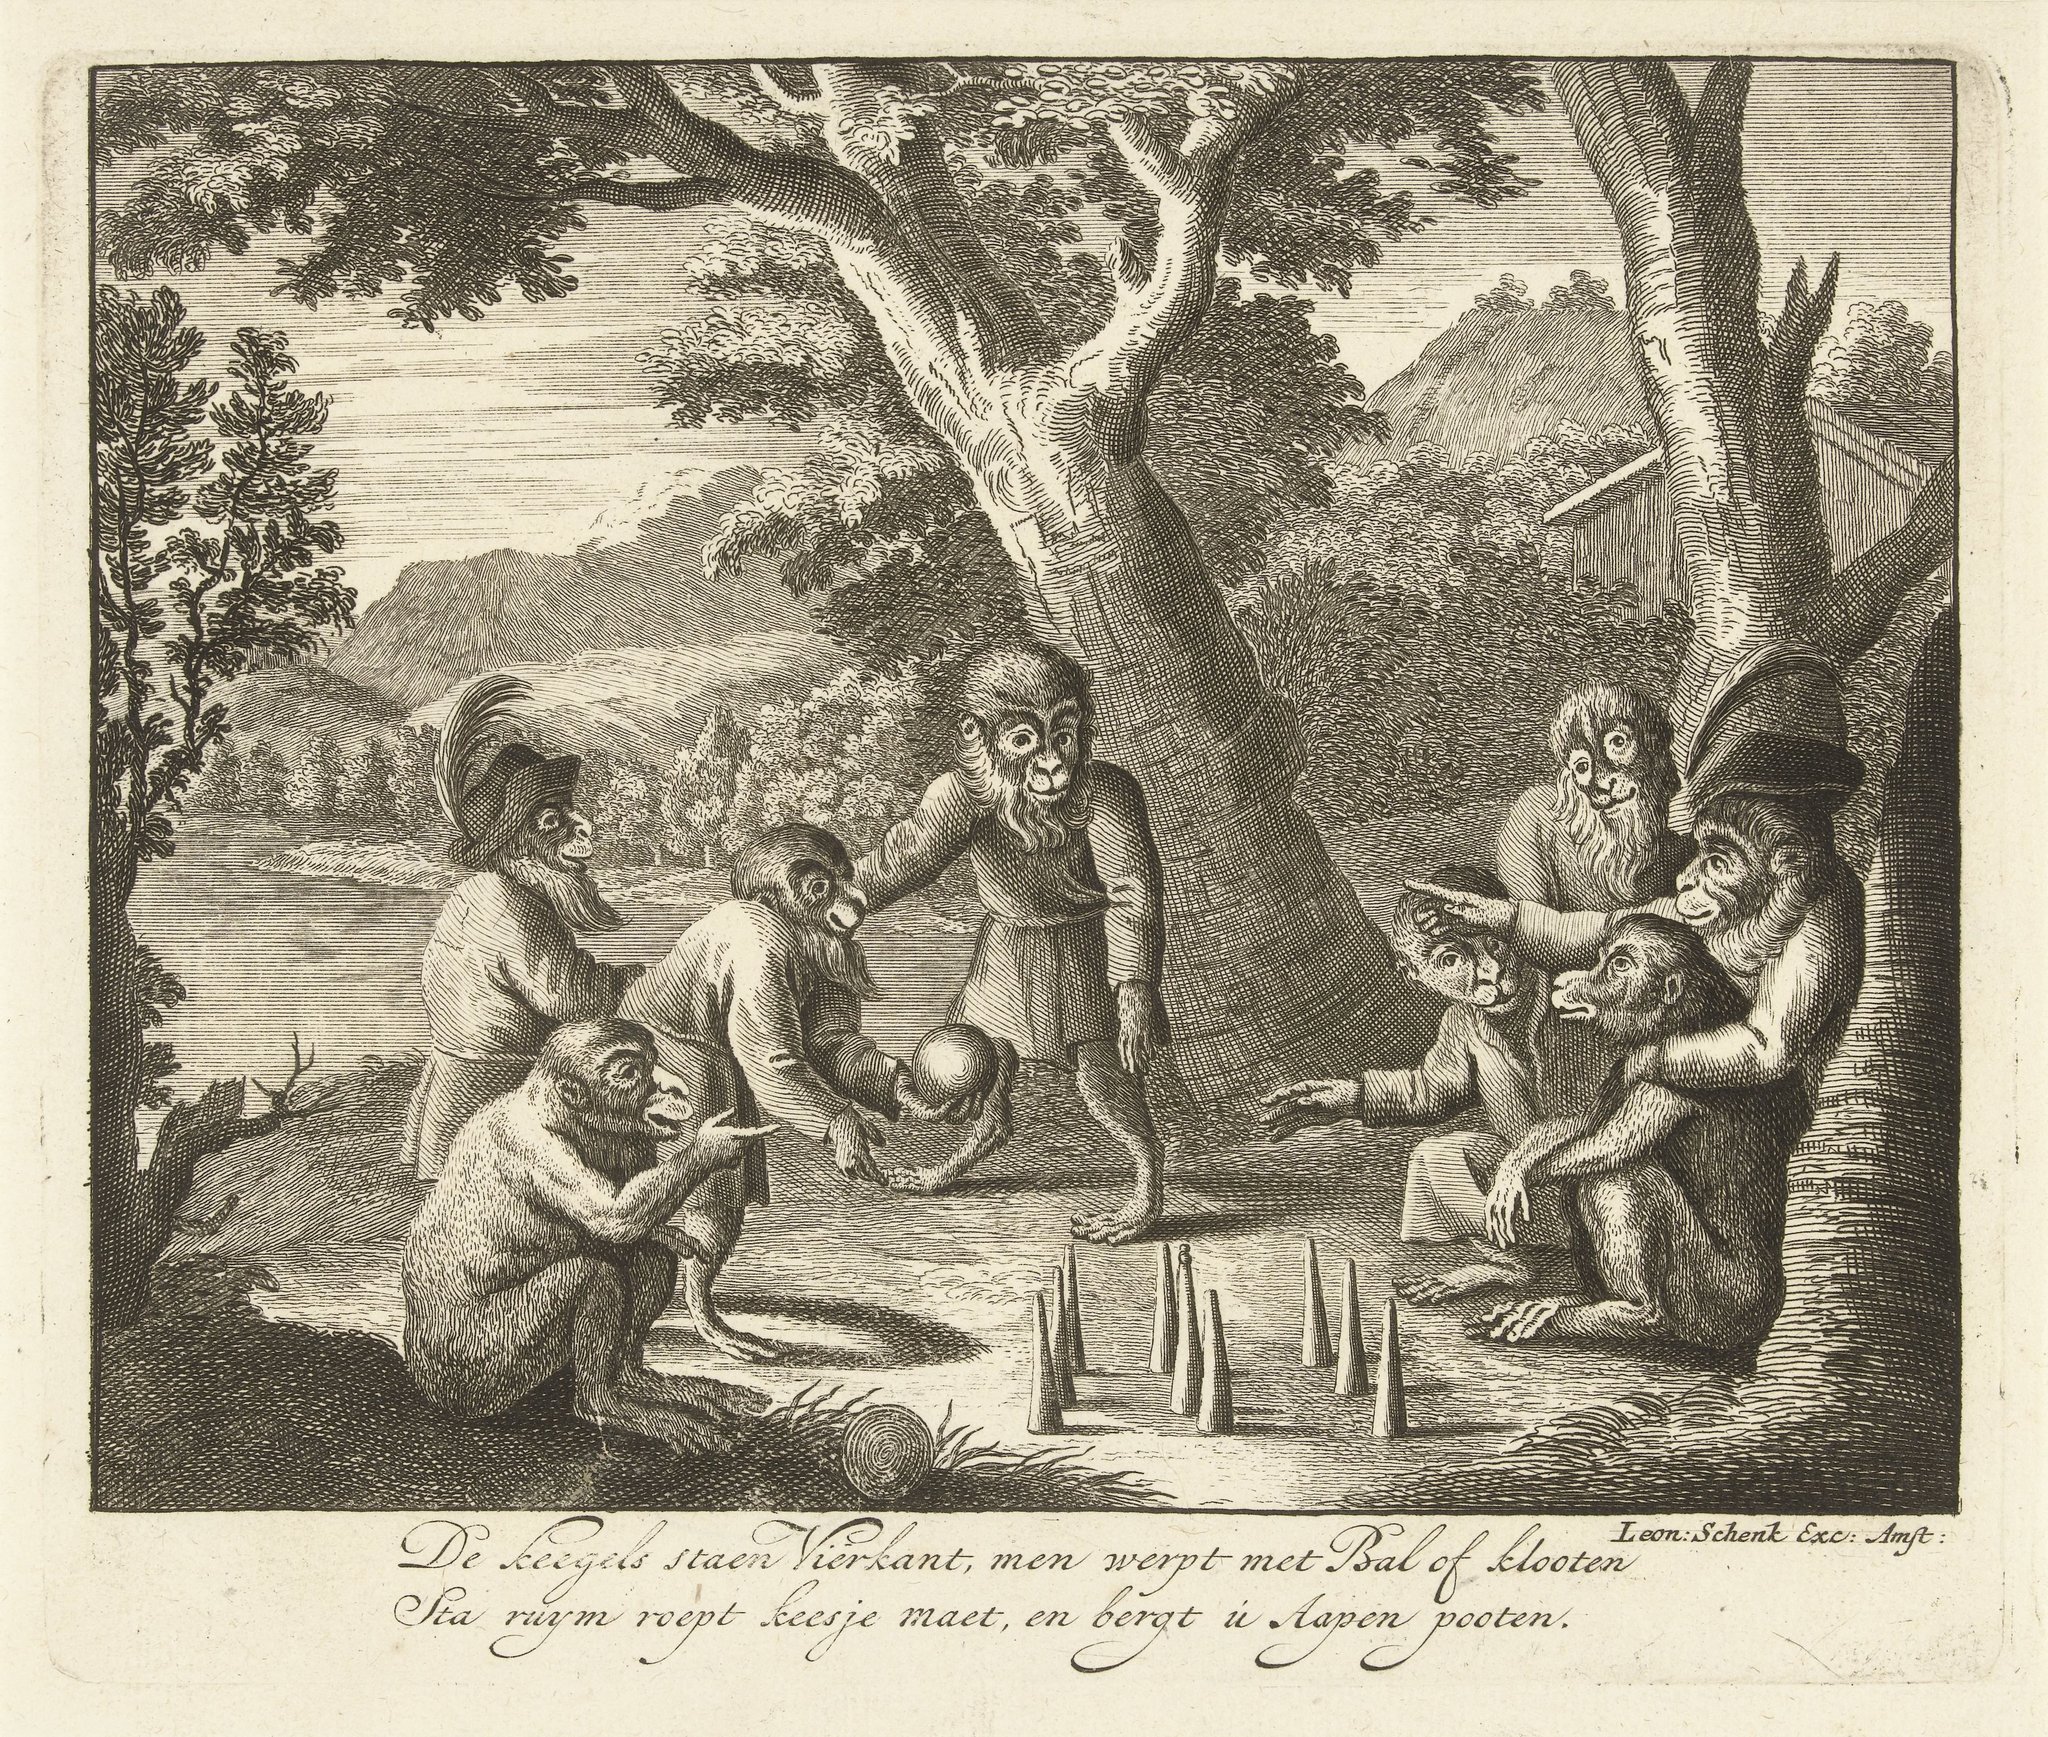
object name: print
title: Apen spelen het kegelspel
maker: leonard schenk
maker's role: print maker, publisher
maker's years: 1696-1767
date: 1720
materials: paper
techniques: engraving, etching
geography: amsterdam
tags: bowling (+ out of doors (sports, games, etc.)), monkeys, apes, animals acting as human beings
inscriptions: collector's mark: Lugt 2228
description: Apen spelen het kegelspel. Onderdeel van een serie bestaande uit een titelprent met 16 ongenummerde platen uit ca. 1720 waarin apen als mensen figureren in allerlei taferelen uit het dagelijks leven. Elke prent met een tweeregelig vers in het onderschrift.